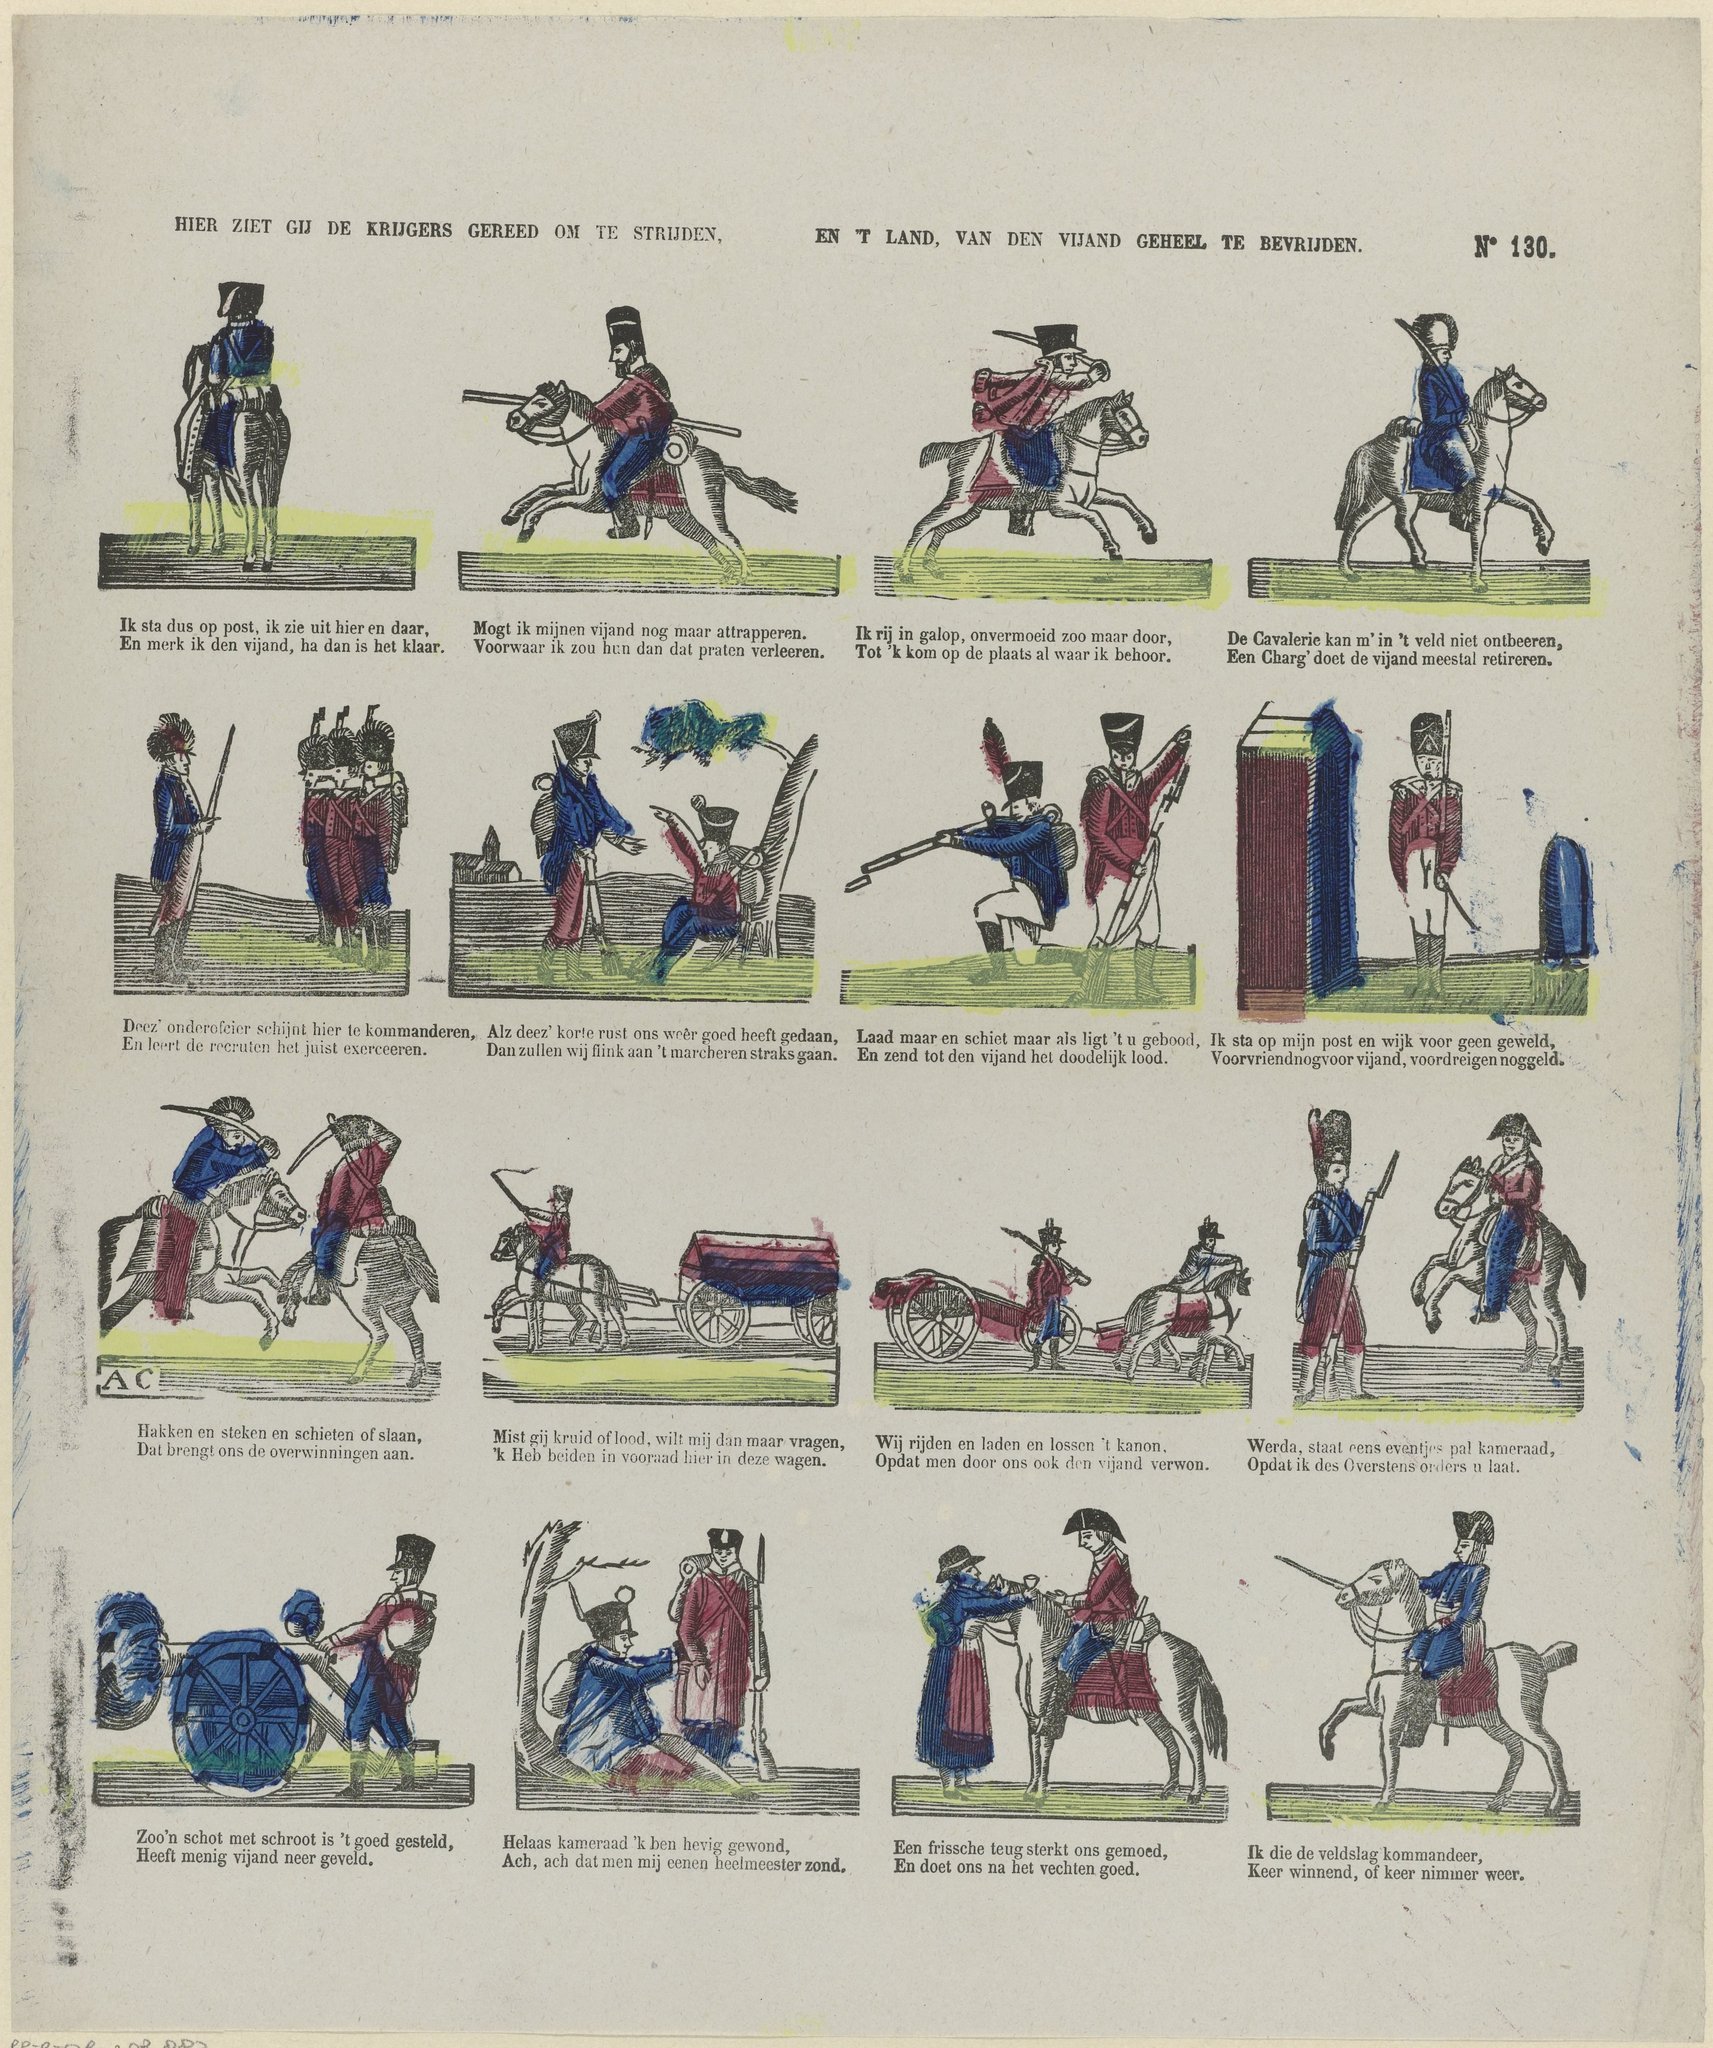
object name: popular print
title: Hier ziet gij de krijgers gereed om te strijden, / En 't land, van den vijand geheel te bevrijden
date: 1827-1894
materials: paper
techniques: colour, letterpress printing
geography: netherlands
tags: artillery range, firing range, shooting range ~ military training, warfare; military affairs (+ cavalry, horsemen), the soldier; the soldier's life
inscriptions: collector's mark: Lugt 2760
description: Blad met 16 voorstellingen van militairen. Onder elke afbeelding een tweeregelig vers. Genummerd rechtsboven: No 130.